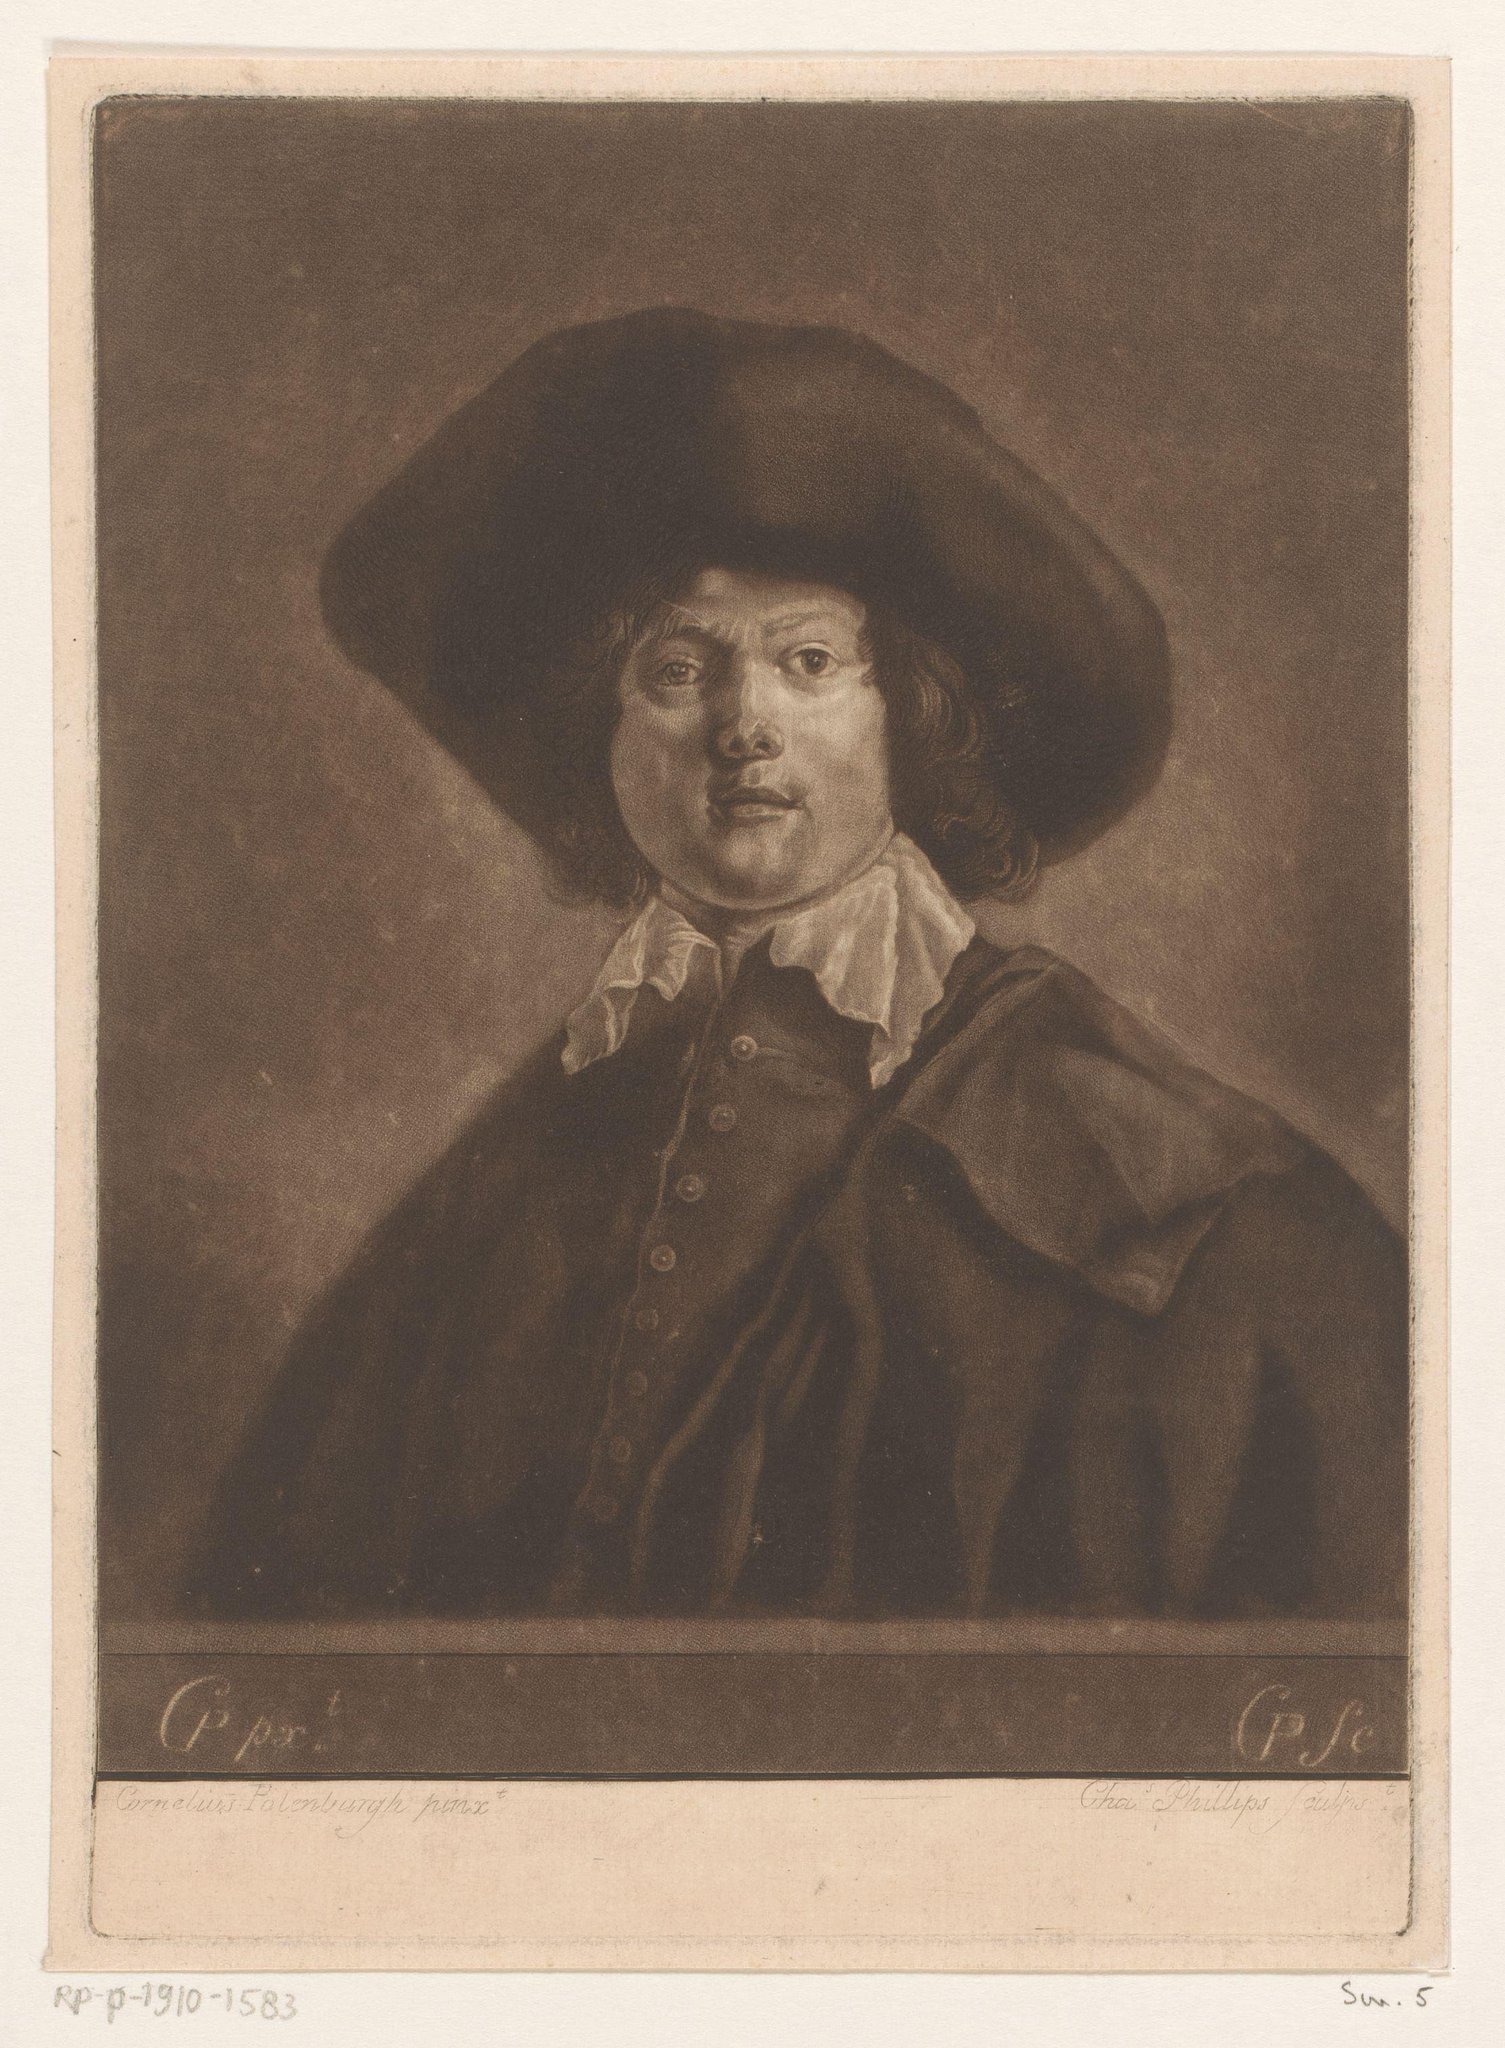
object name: print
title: Portret van een onbekende man met een hoed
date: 1747-1773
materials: paper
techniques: mezzotint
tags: historical persons, head-gear: hat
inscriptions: collector's mark: Lugt 2228